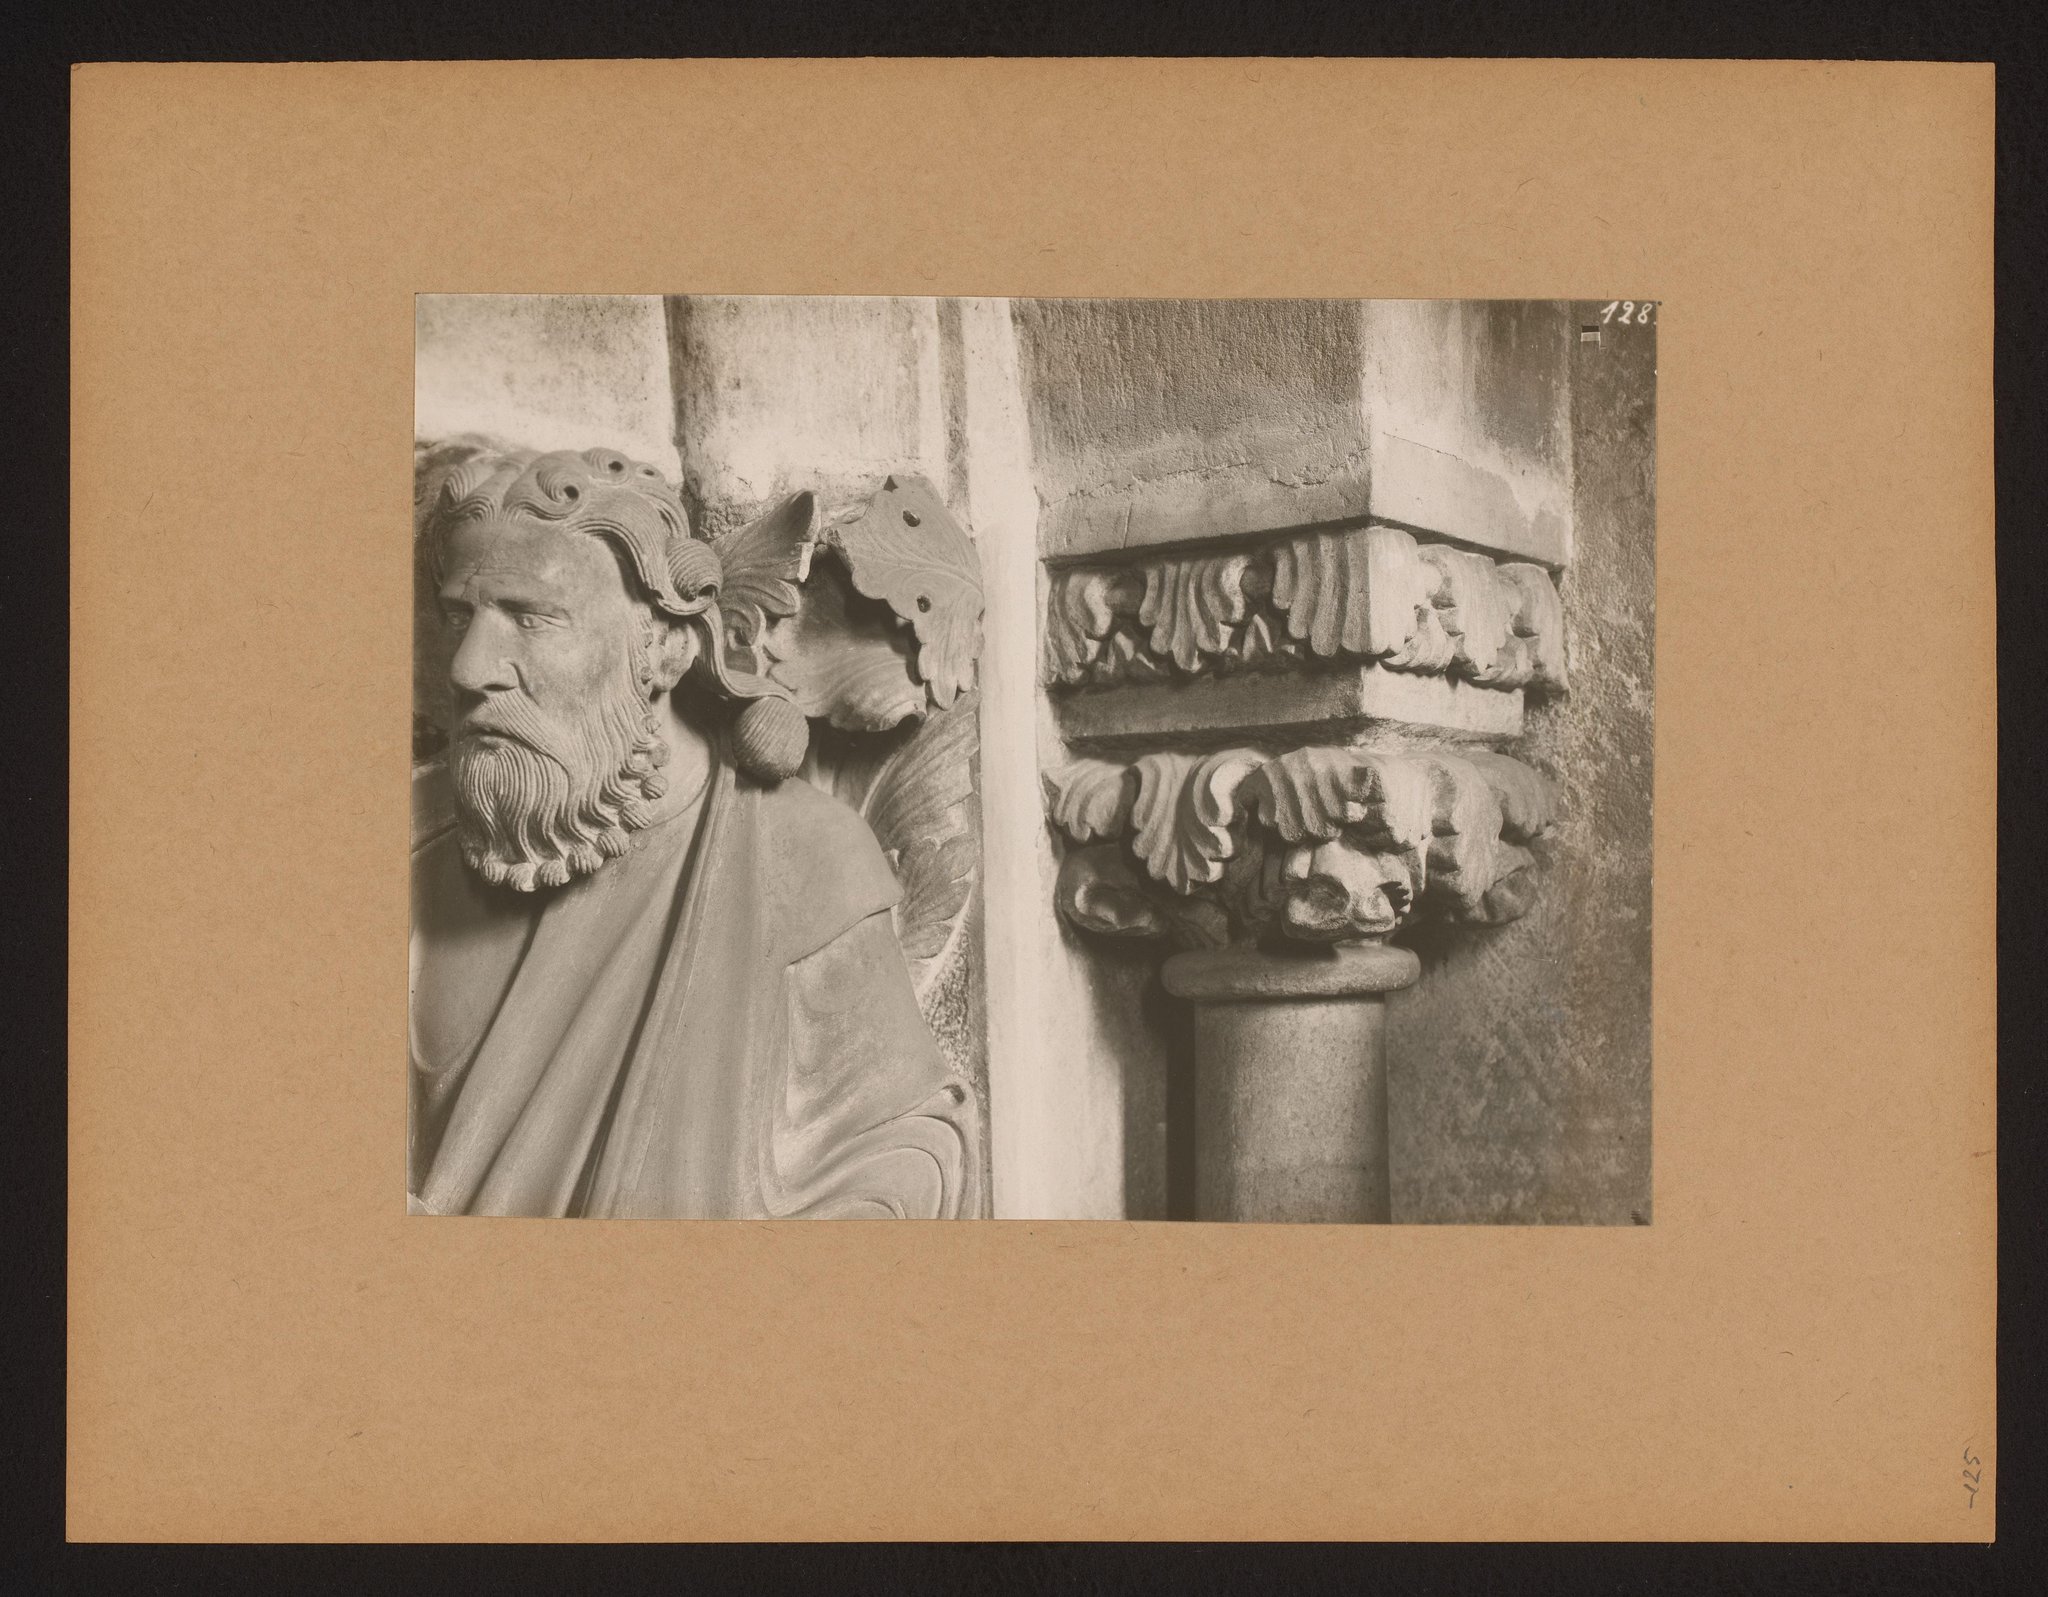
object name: photograph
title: Detail van het doksaal in het Ostchor van de dom van Bamberg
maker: Anonymous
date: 1900-1920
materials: paper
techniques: gelatin silver print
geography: bamberg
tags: interior of church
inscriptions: number: ‘128’